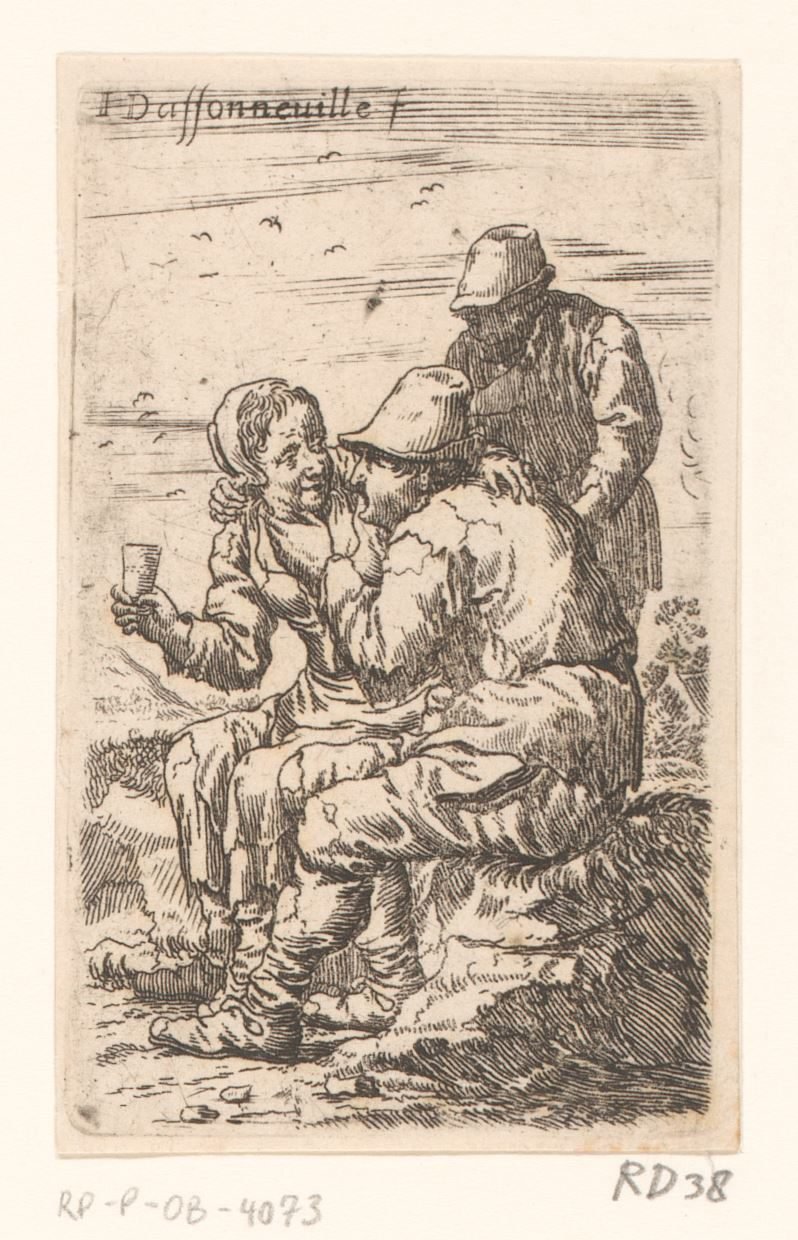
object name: print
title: Man en vrouw in omhelzing met achter hen een staande man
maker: jacques dassonville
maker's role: print maker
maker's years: 1619-1670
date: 1629-1670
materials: paper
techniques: engraving, etching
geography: france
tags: embracing each other, kissing